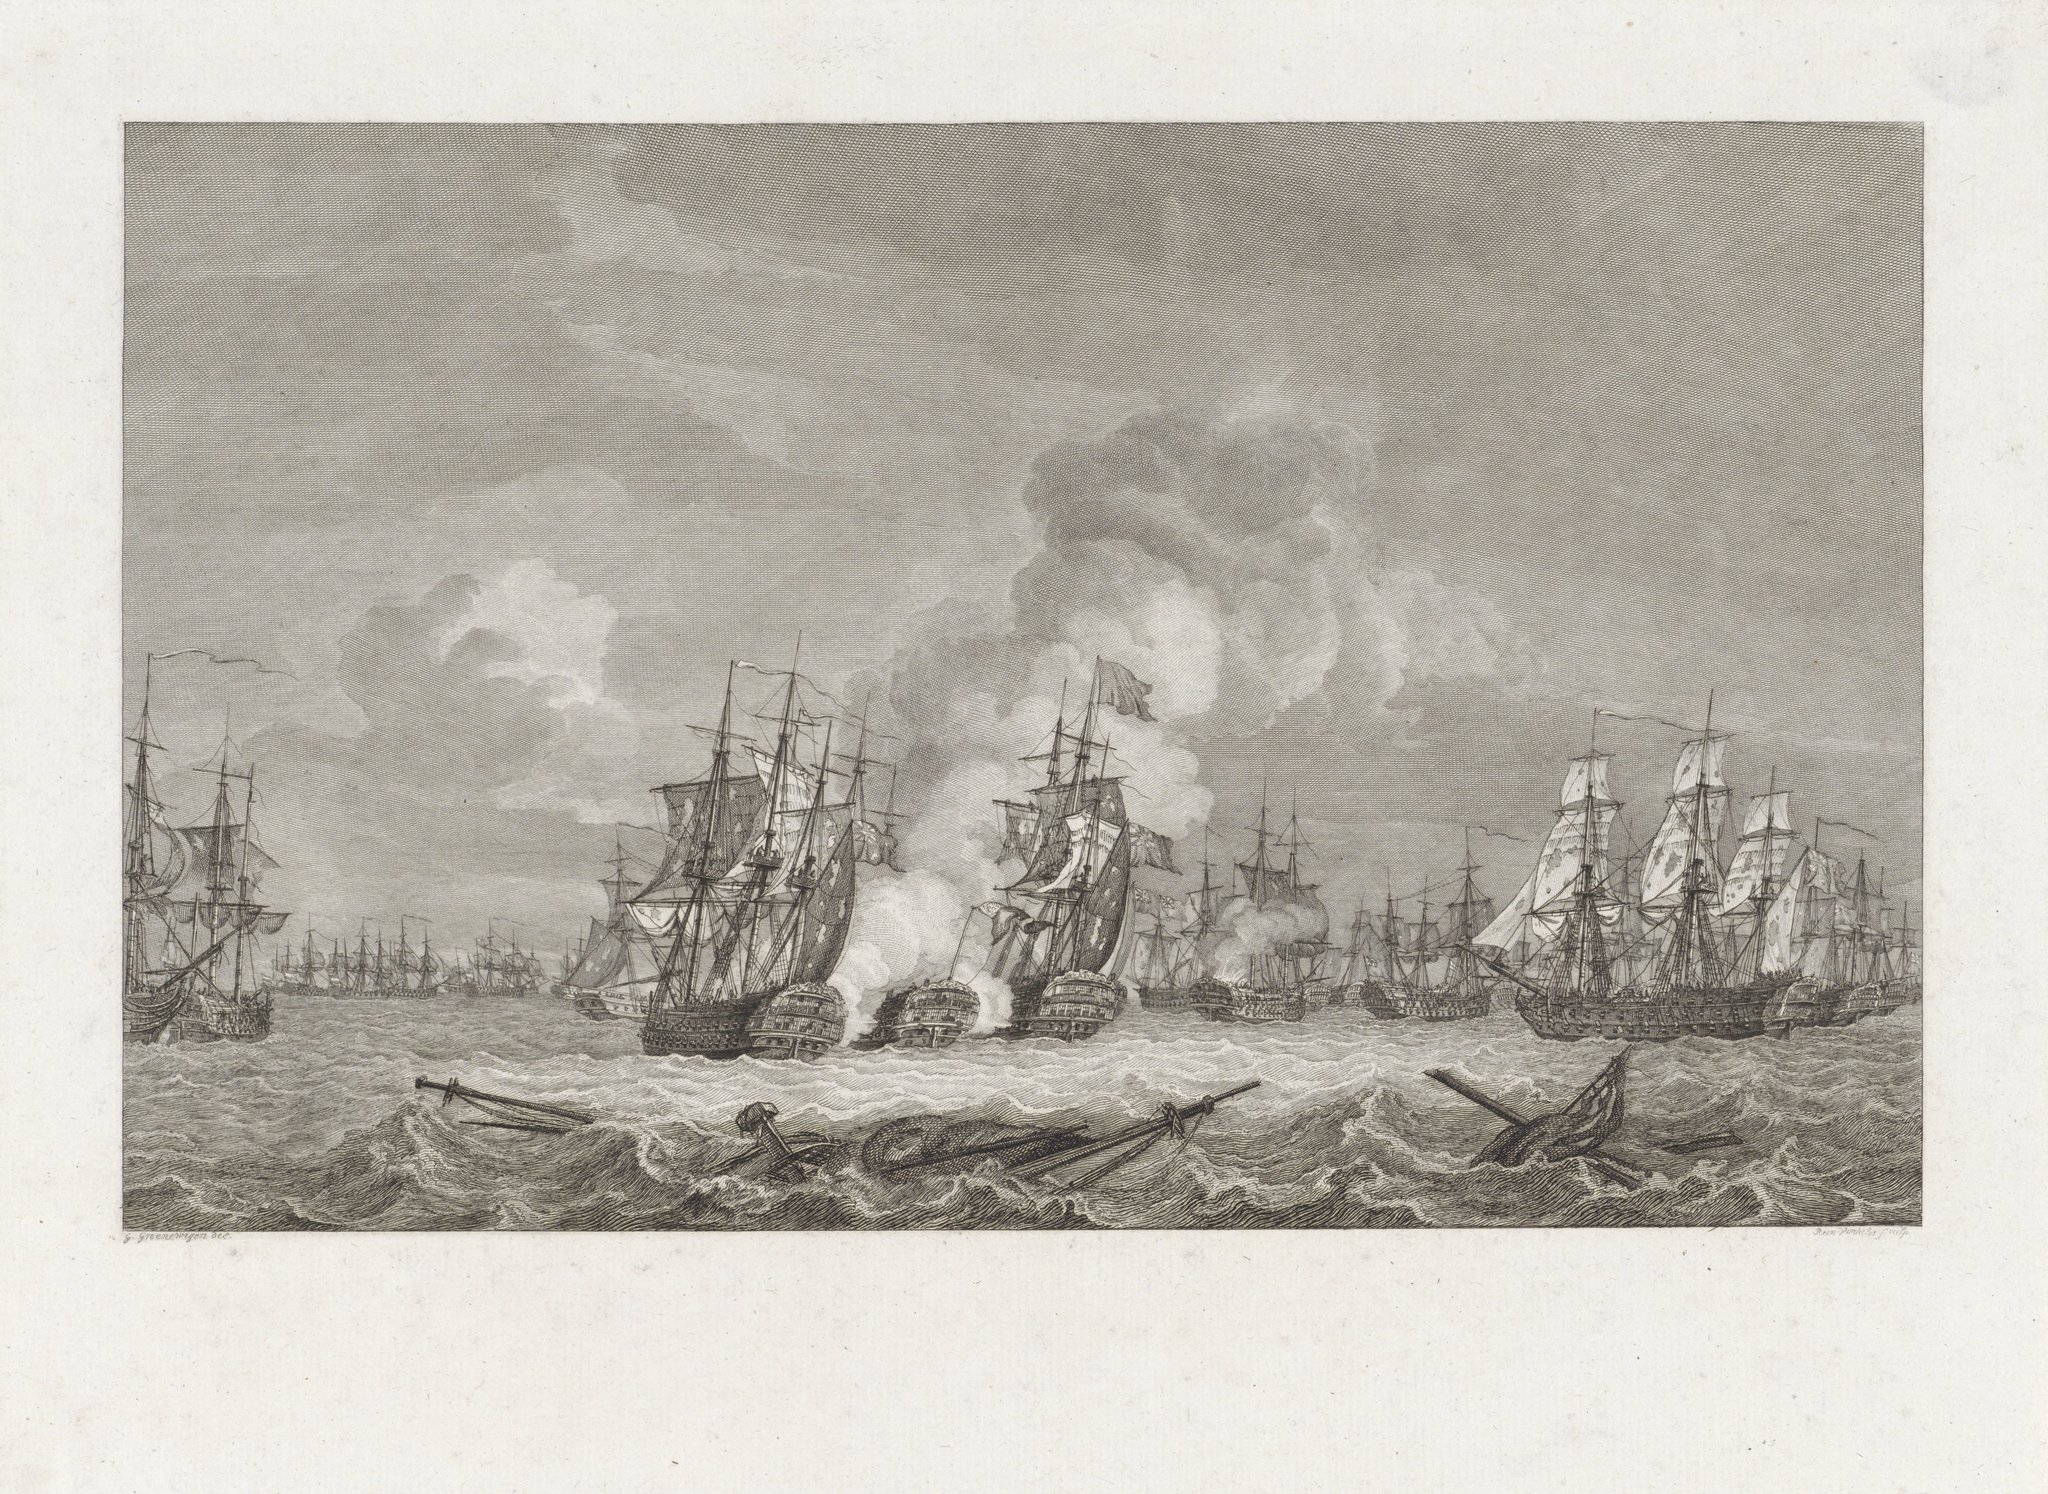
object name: print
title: Drie platen van de zeeslag bij Kamperduin, 1797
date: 1798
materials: paper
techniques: engraving, etching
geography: amsterdam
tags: battle (+ naval force), battle of camperdown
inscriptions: collector's mark: Lugt 240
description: De Zeeslag bij Kamperduin op 11 oktober 1797 tussen de Bataafse vloot onder bevel van viceadmiraal Jan Willem de Winter en een Britse vloot onder admiraal Adam Duncan. Einde van de slag. Centraal de Vrijheid (dit schip onder bevel van De Winter) mastloos tussen drie Engelse schepen en de Hercules waarop men nog bezig is de brand te blussen; verder ontredderde Bataafse schepen onder de Engelse schepen.